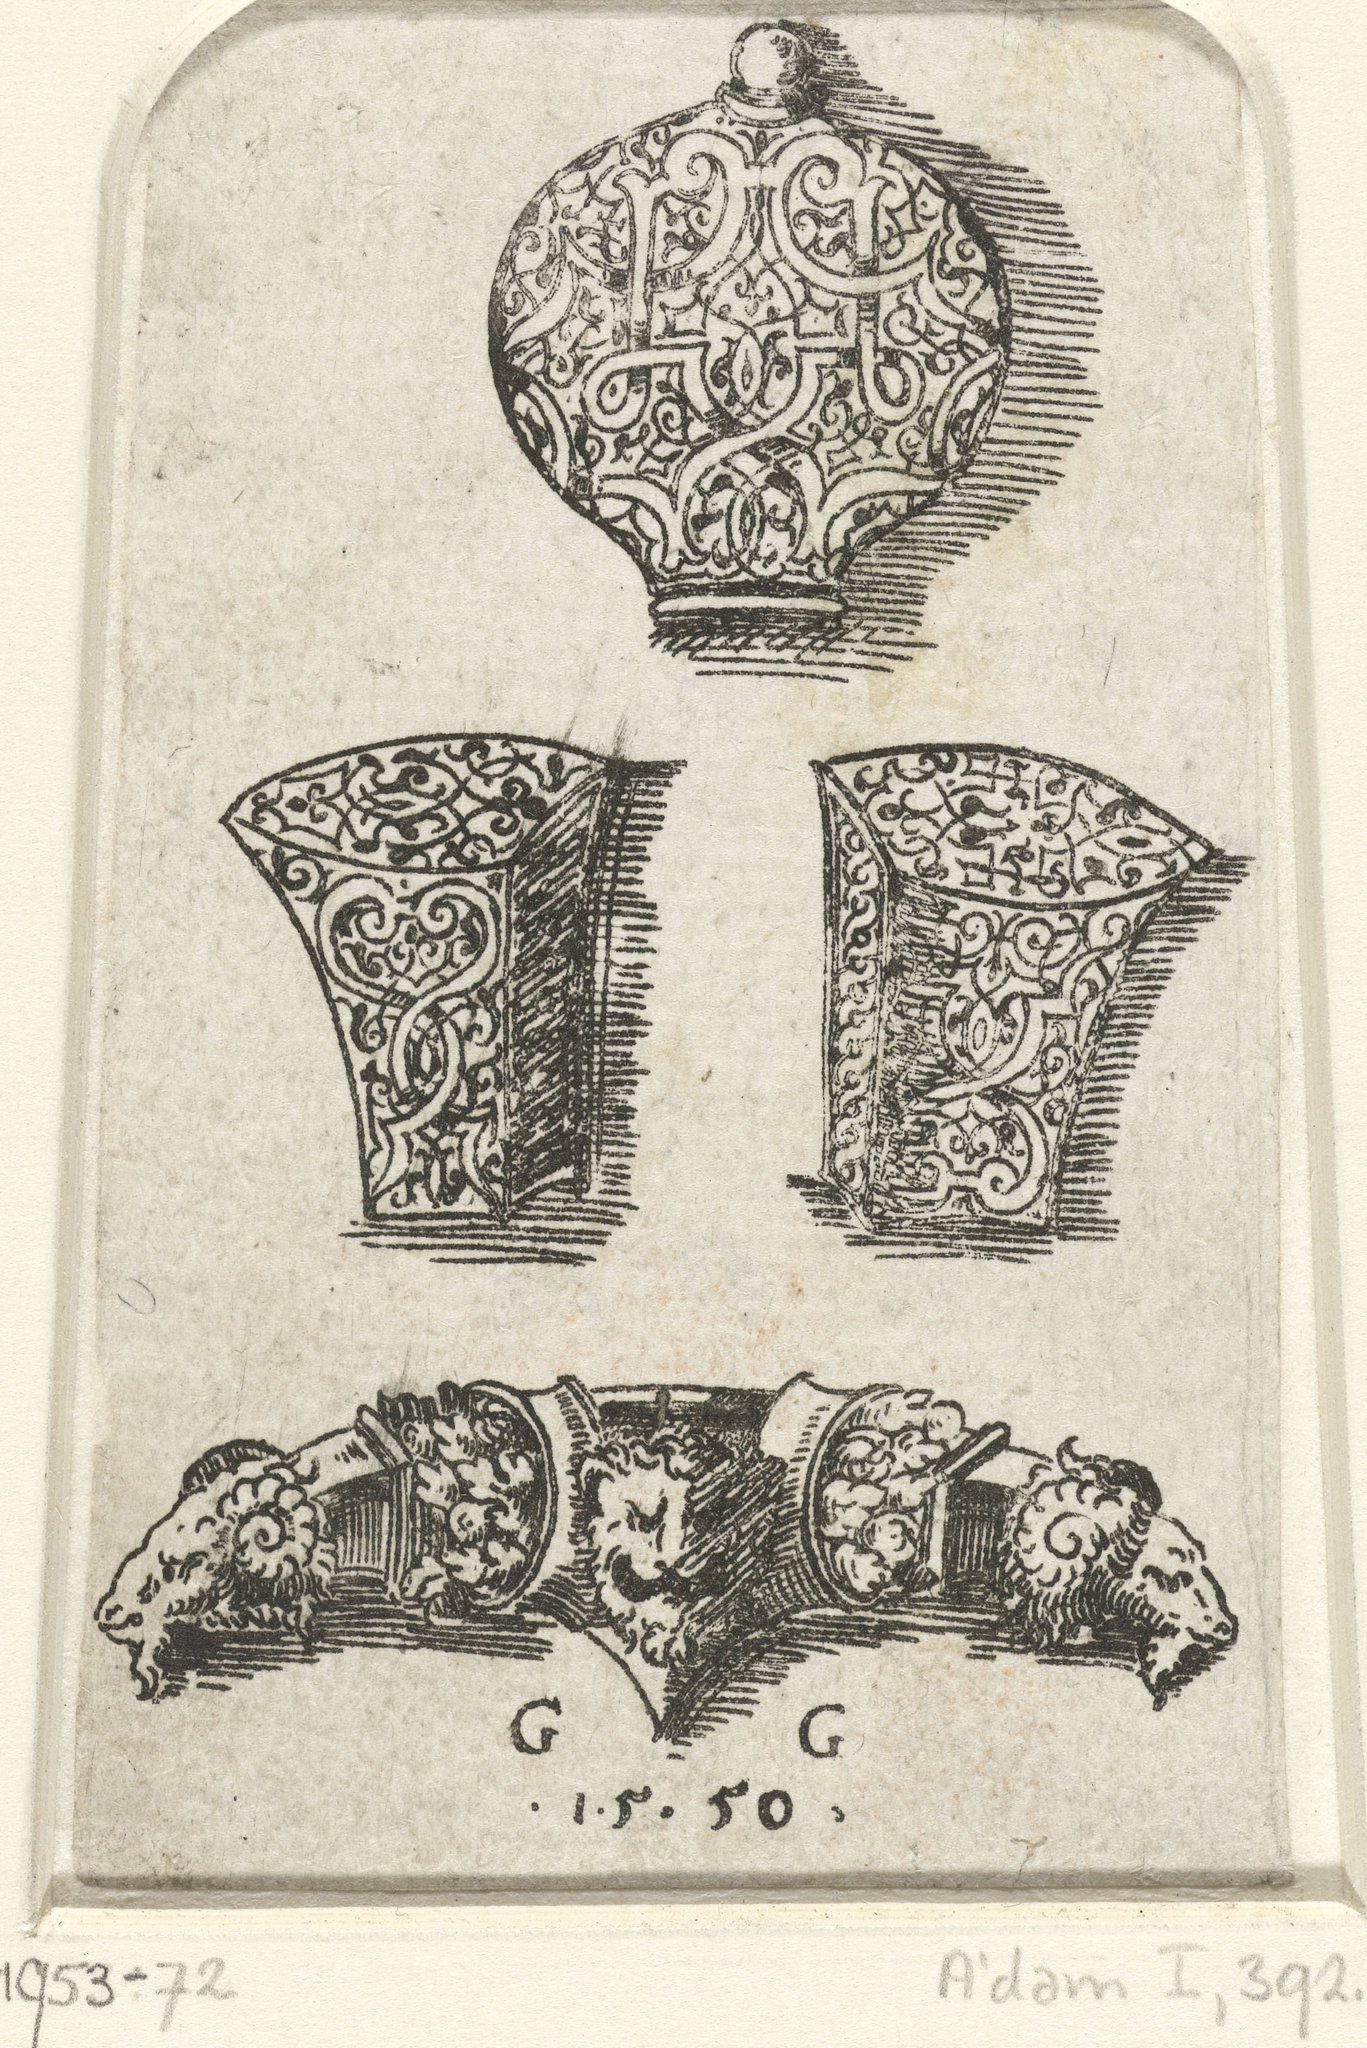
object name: ornament print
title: Degenversieringen, 1550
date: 1550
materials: paper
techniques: etching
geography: germany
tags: ornament ~ moresque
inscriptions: date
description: Bovenaan een knop, daaronder twee grepen en onderaan een pareerstang, gedecoreerd met ramskoppen en een mascaron. Uit een serie van 42 bladen.